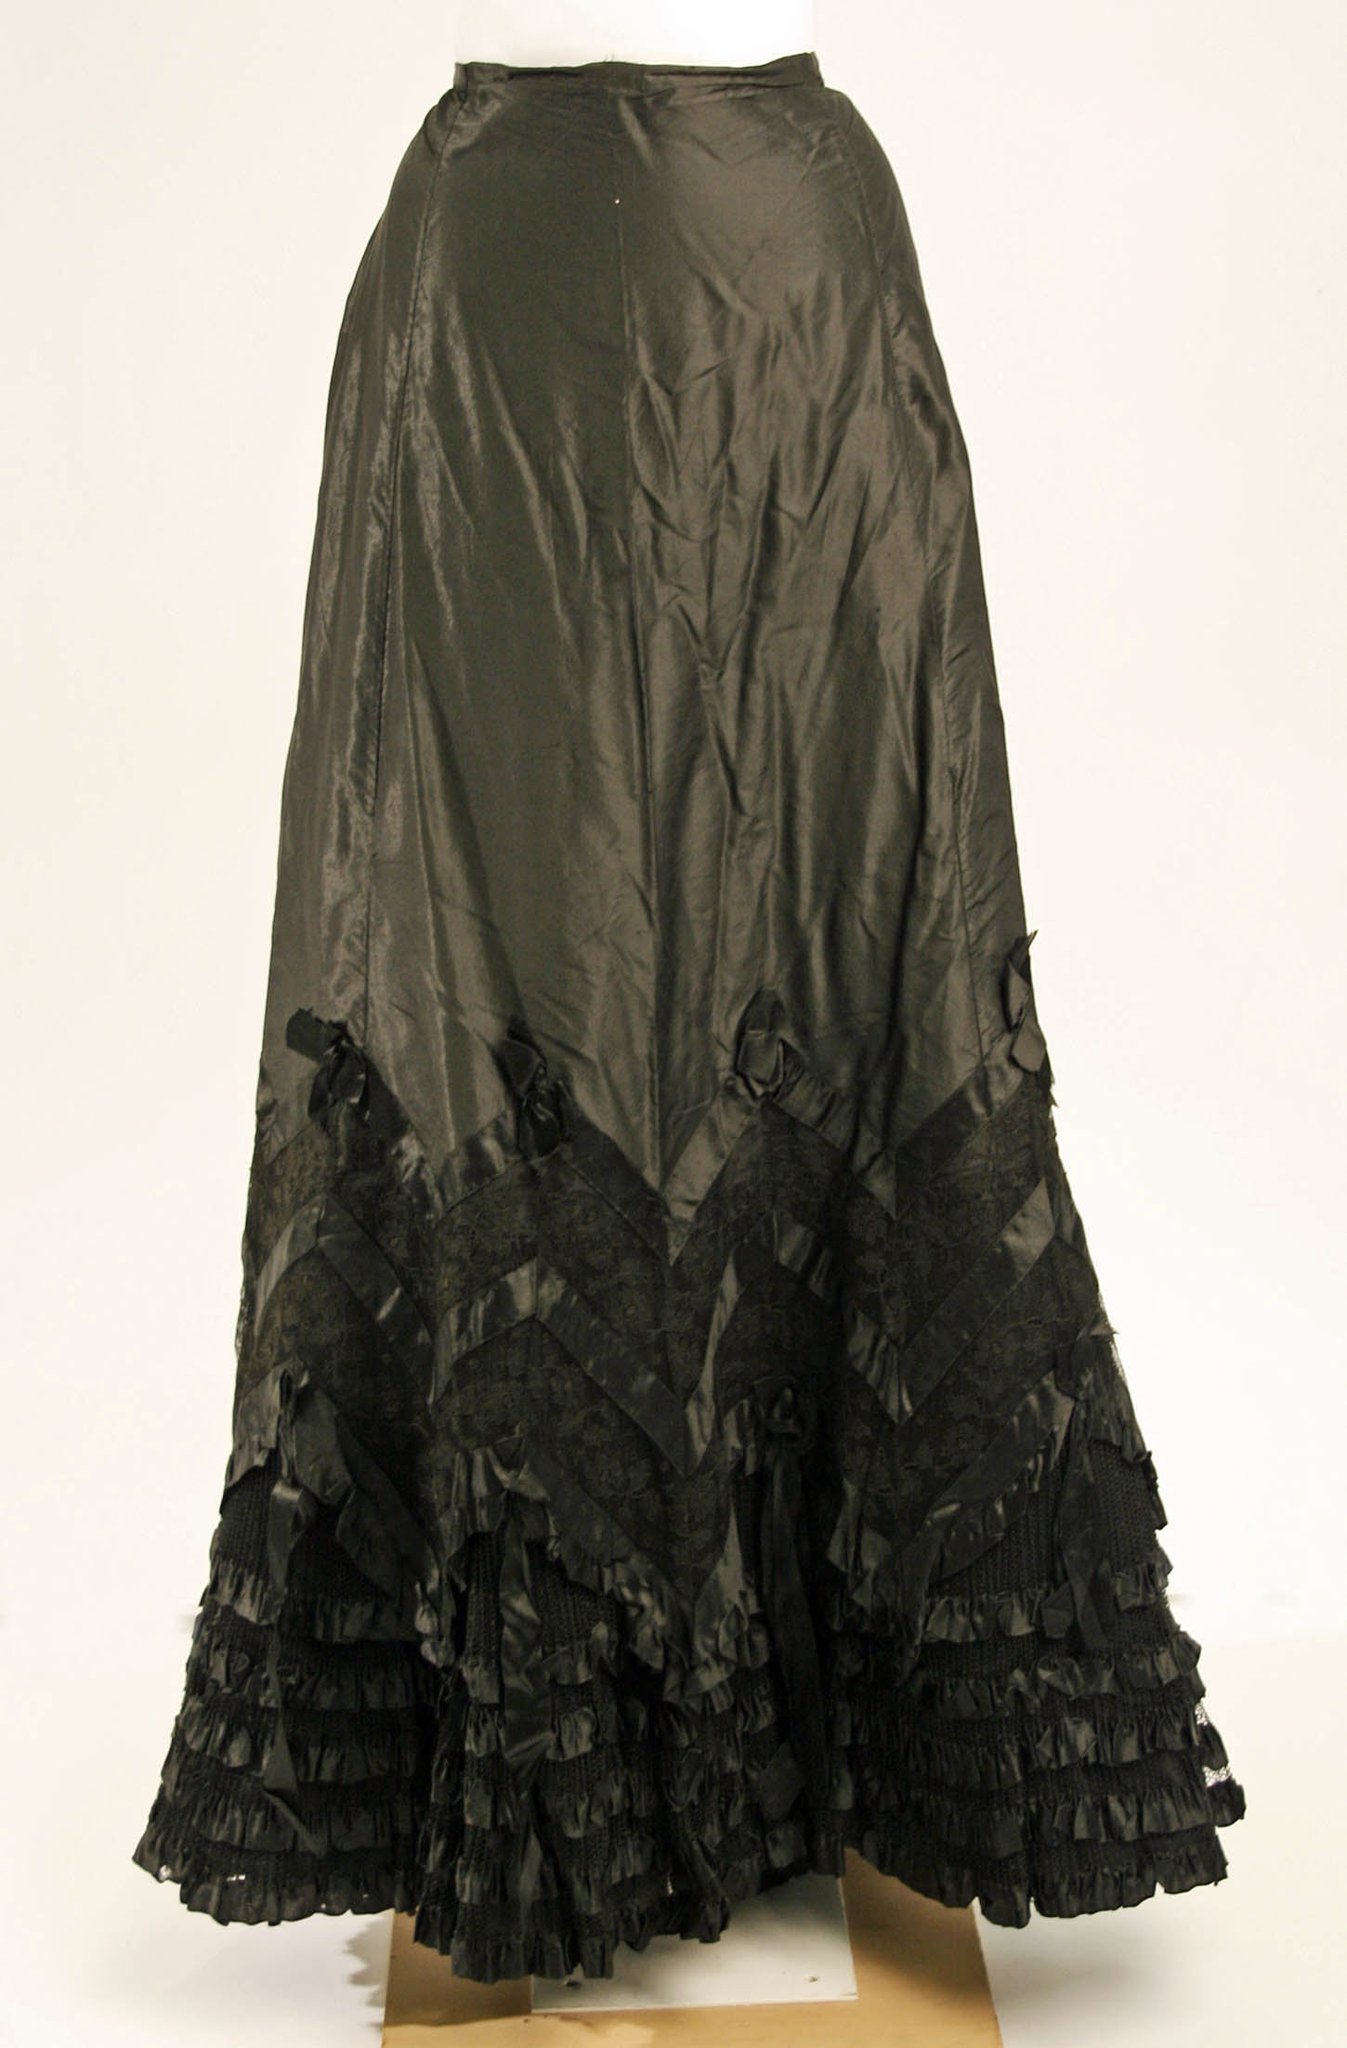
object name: underskirt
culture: french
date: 1893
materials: silk